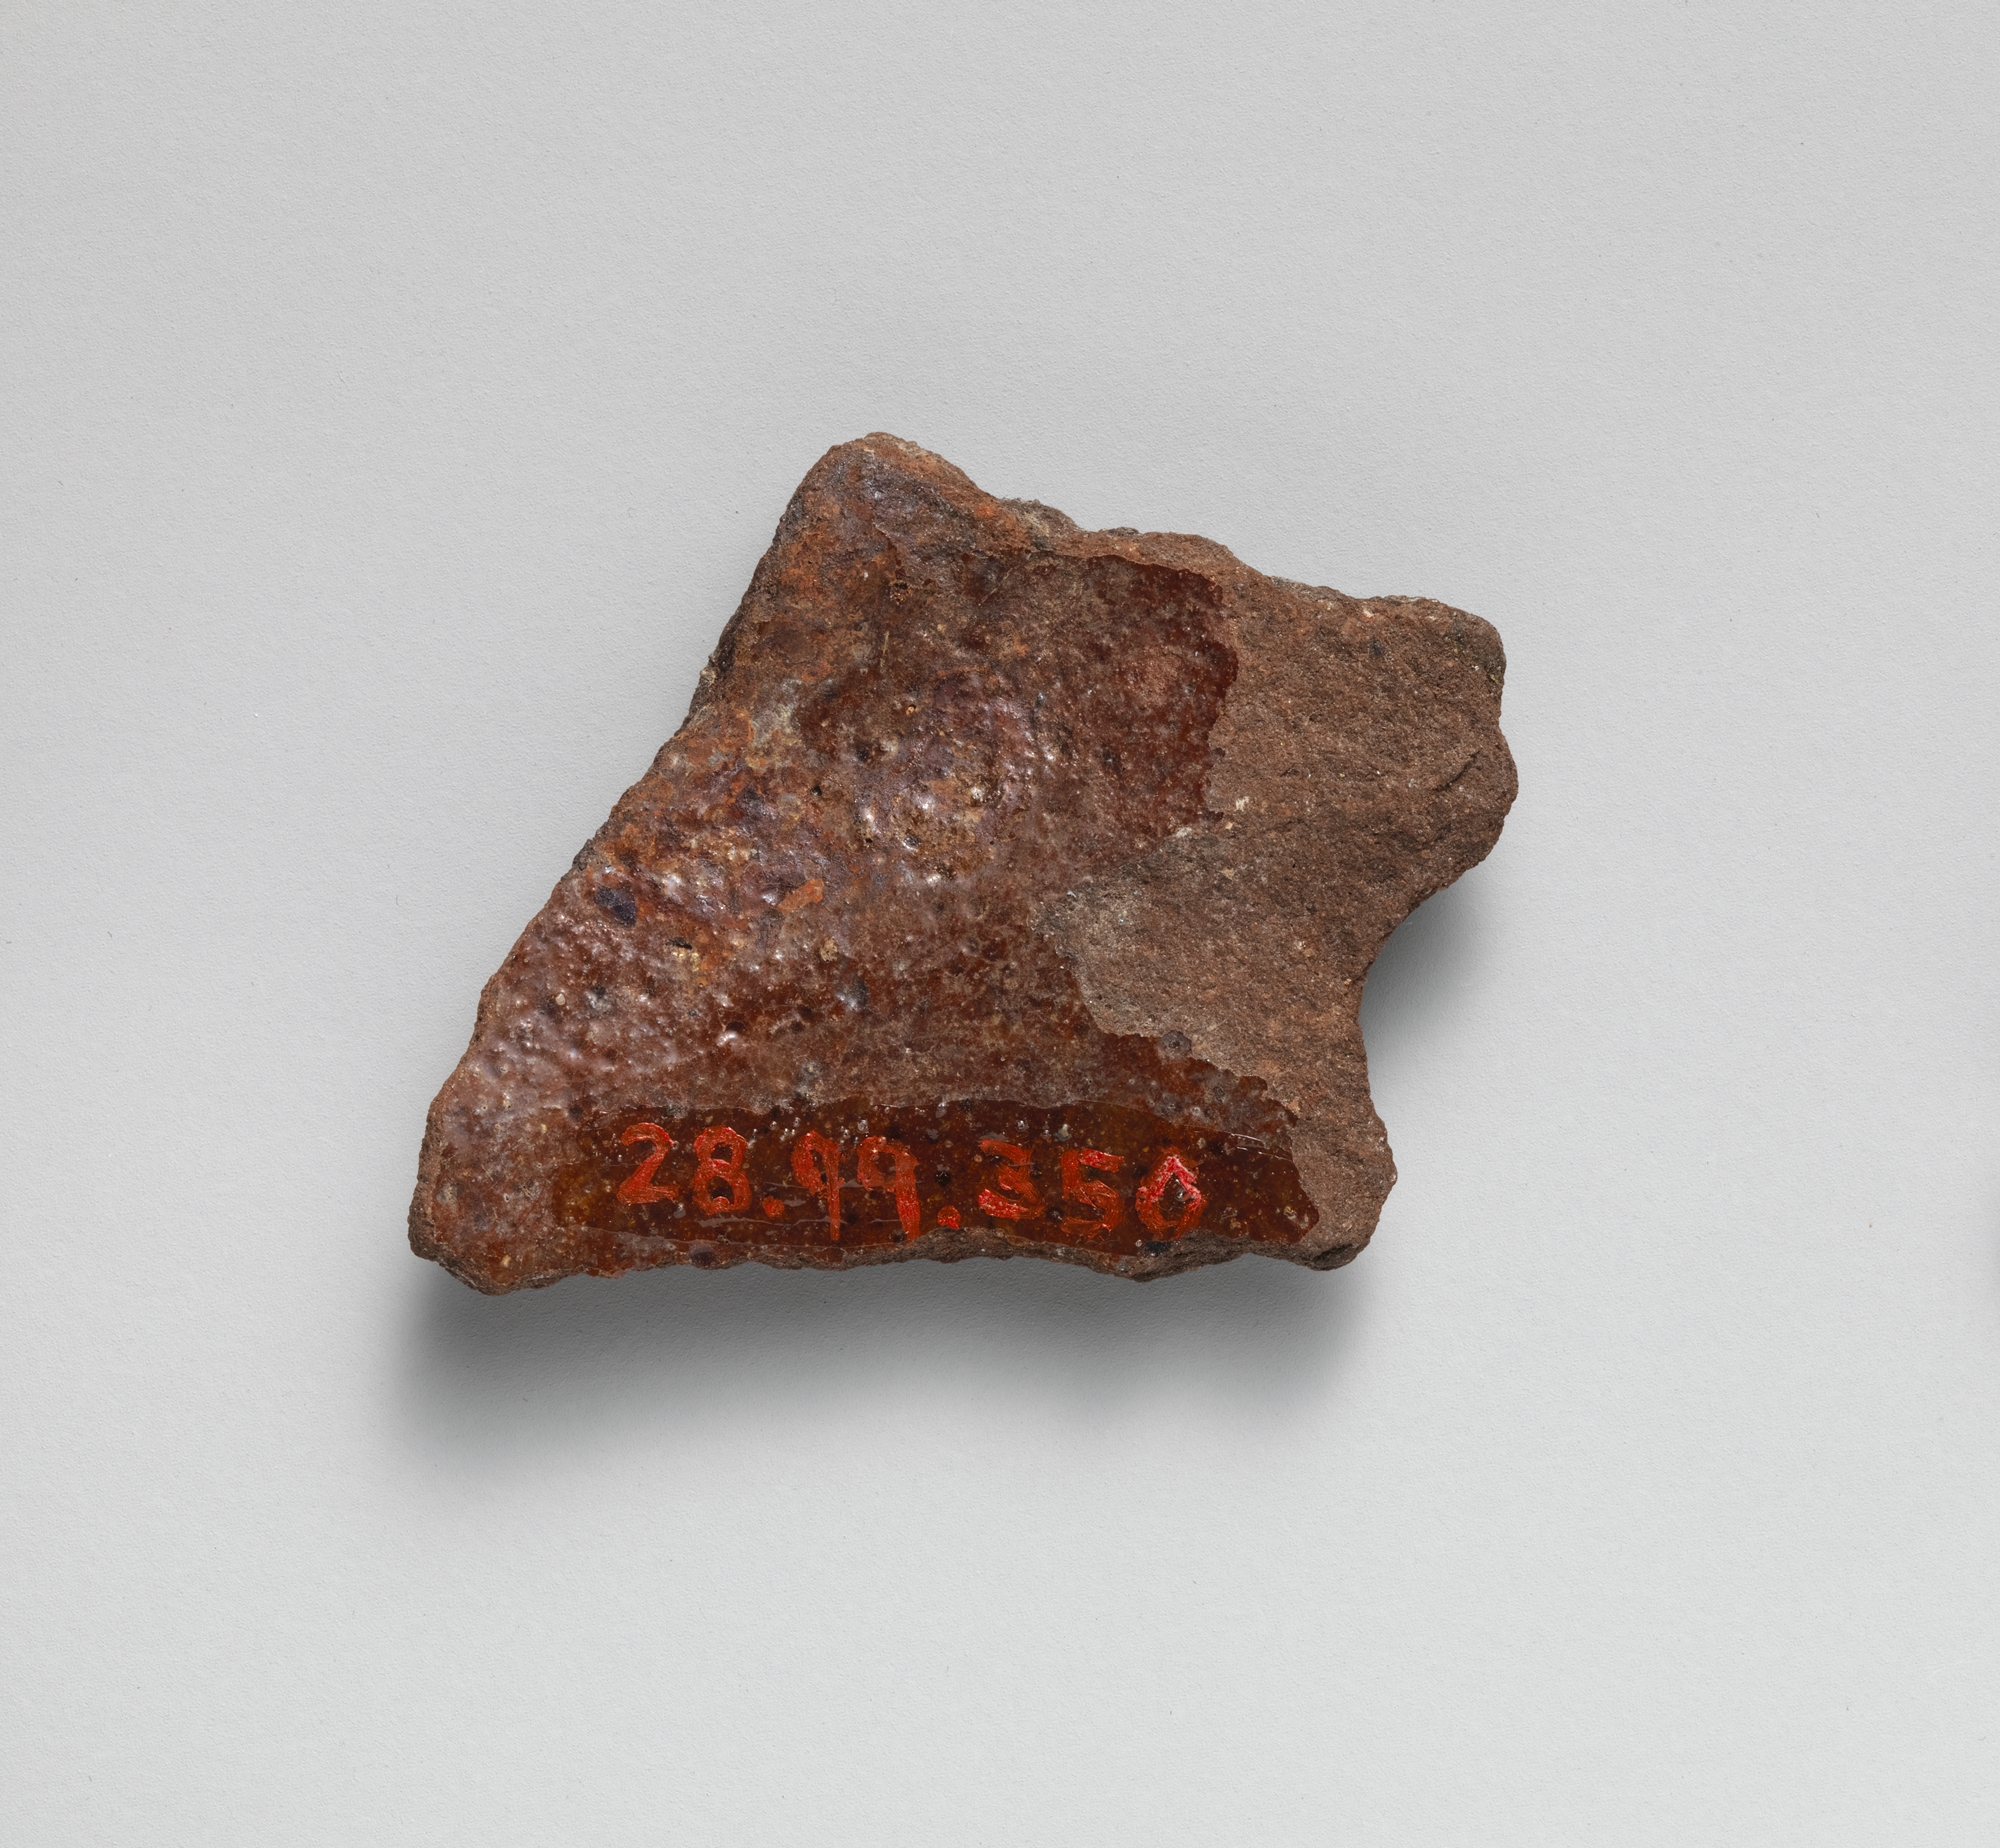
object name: fragment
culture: european or middle eastern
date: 1150-1250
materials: ceramic